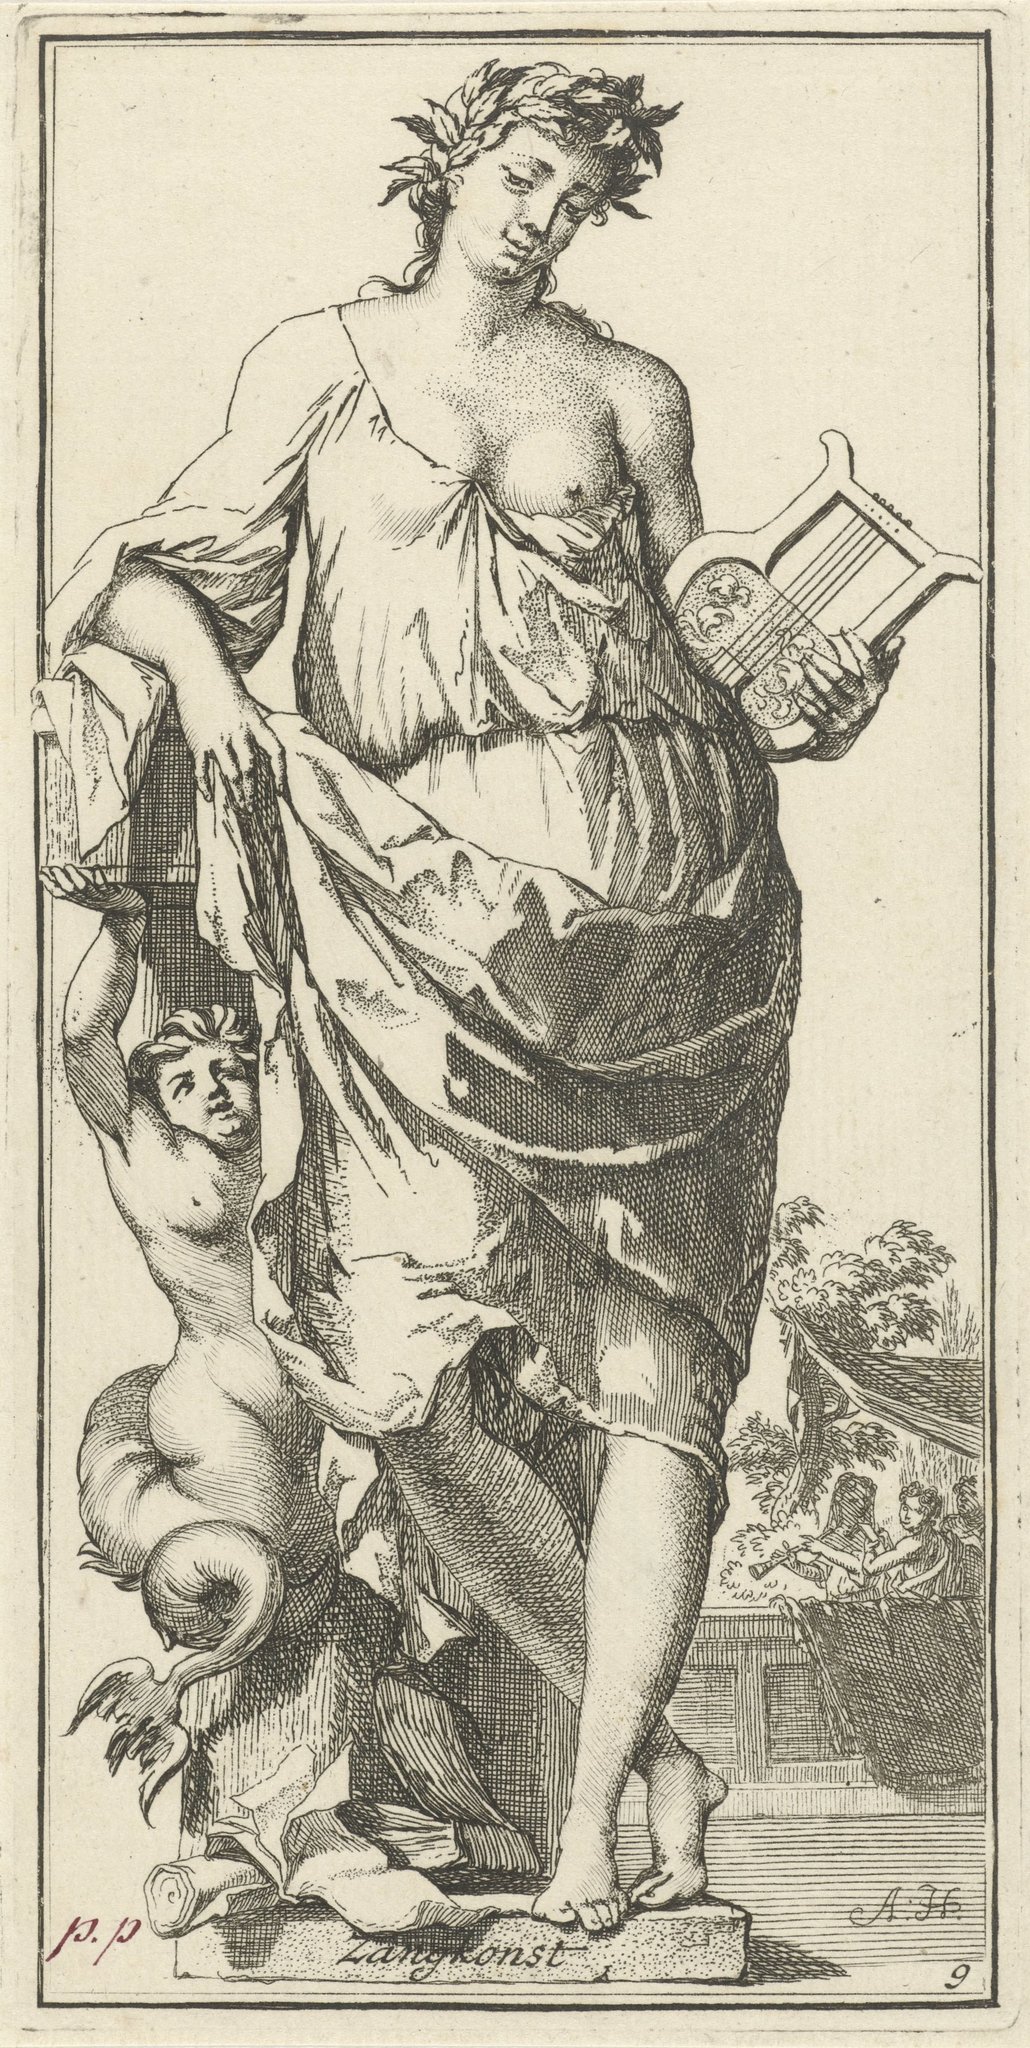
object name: print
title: Zangkonst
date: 1710-1719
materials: paper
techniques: engraving, etching, pen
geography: amsterdam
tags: lyre, cithara, psaltery, vocal music, singing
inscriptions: inscription: ‘p.p’, collector's mark: Lugt 2228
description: Een halfnaakte vrouwfiguur als personificatie van de zangkunst met in haar rechterhand een lier en haar linkerarm rustend op een zuil die wordt ondersteund door een half menselijk figuur. Om haar hoofd een lauwerkrans. Op de achtergrond een musicerend gezelschap. Prent uit een serie van 41 zinnebeelden.